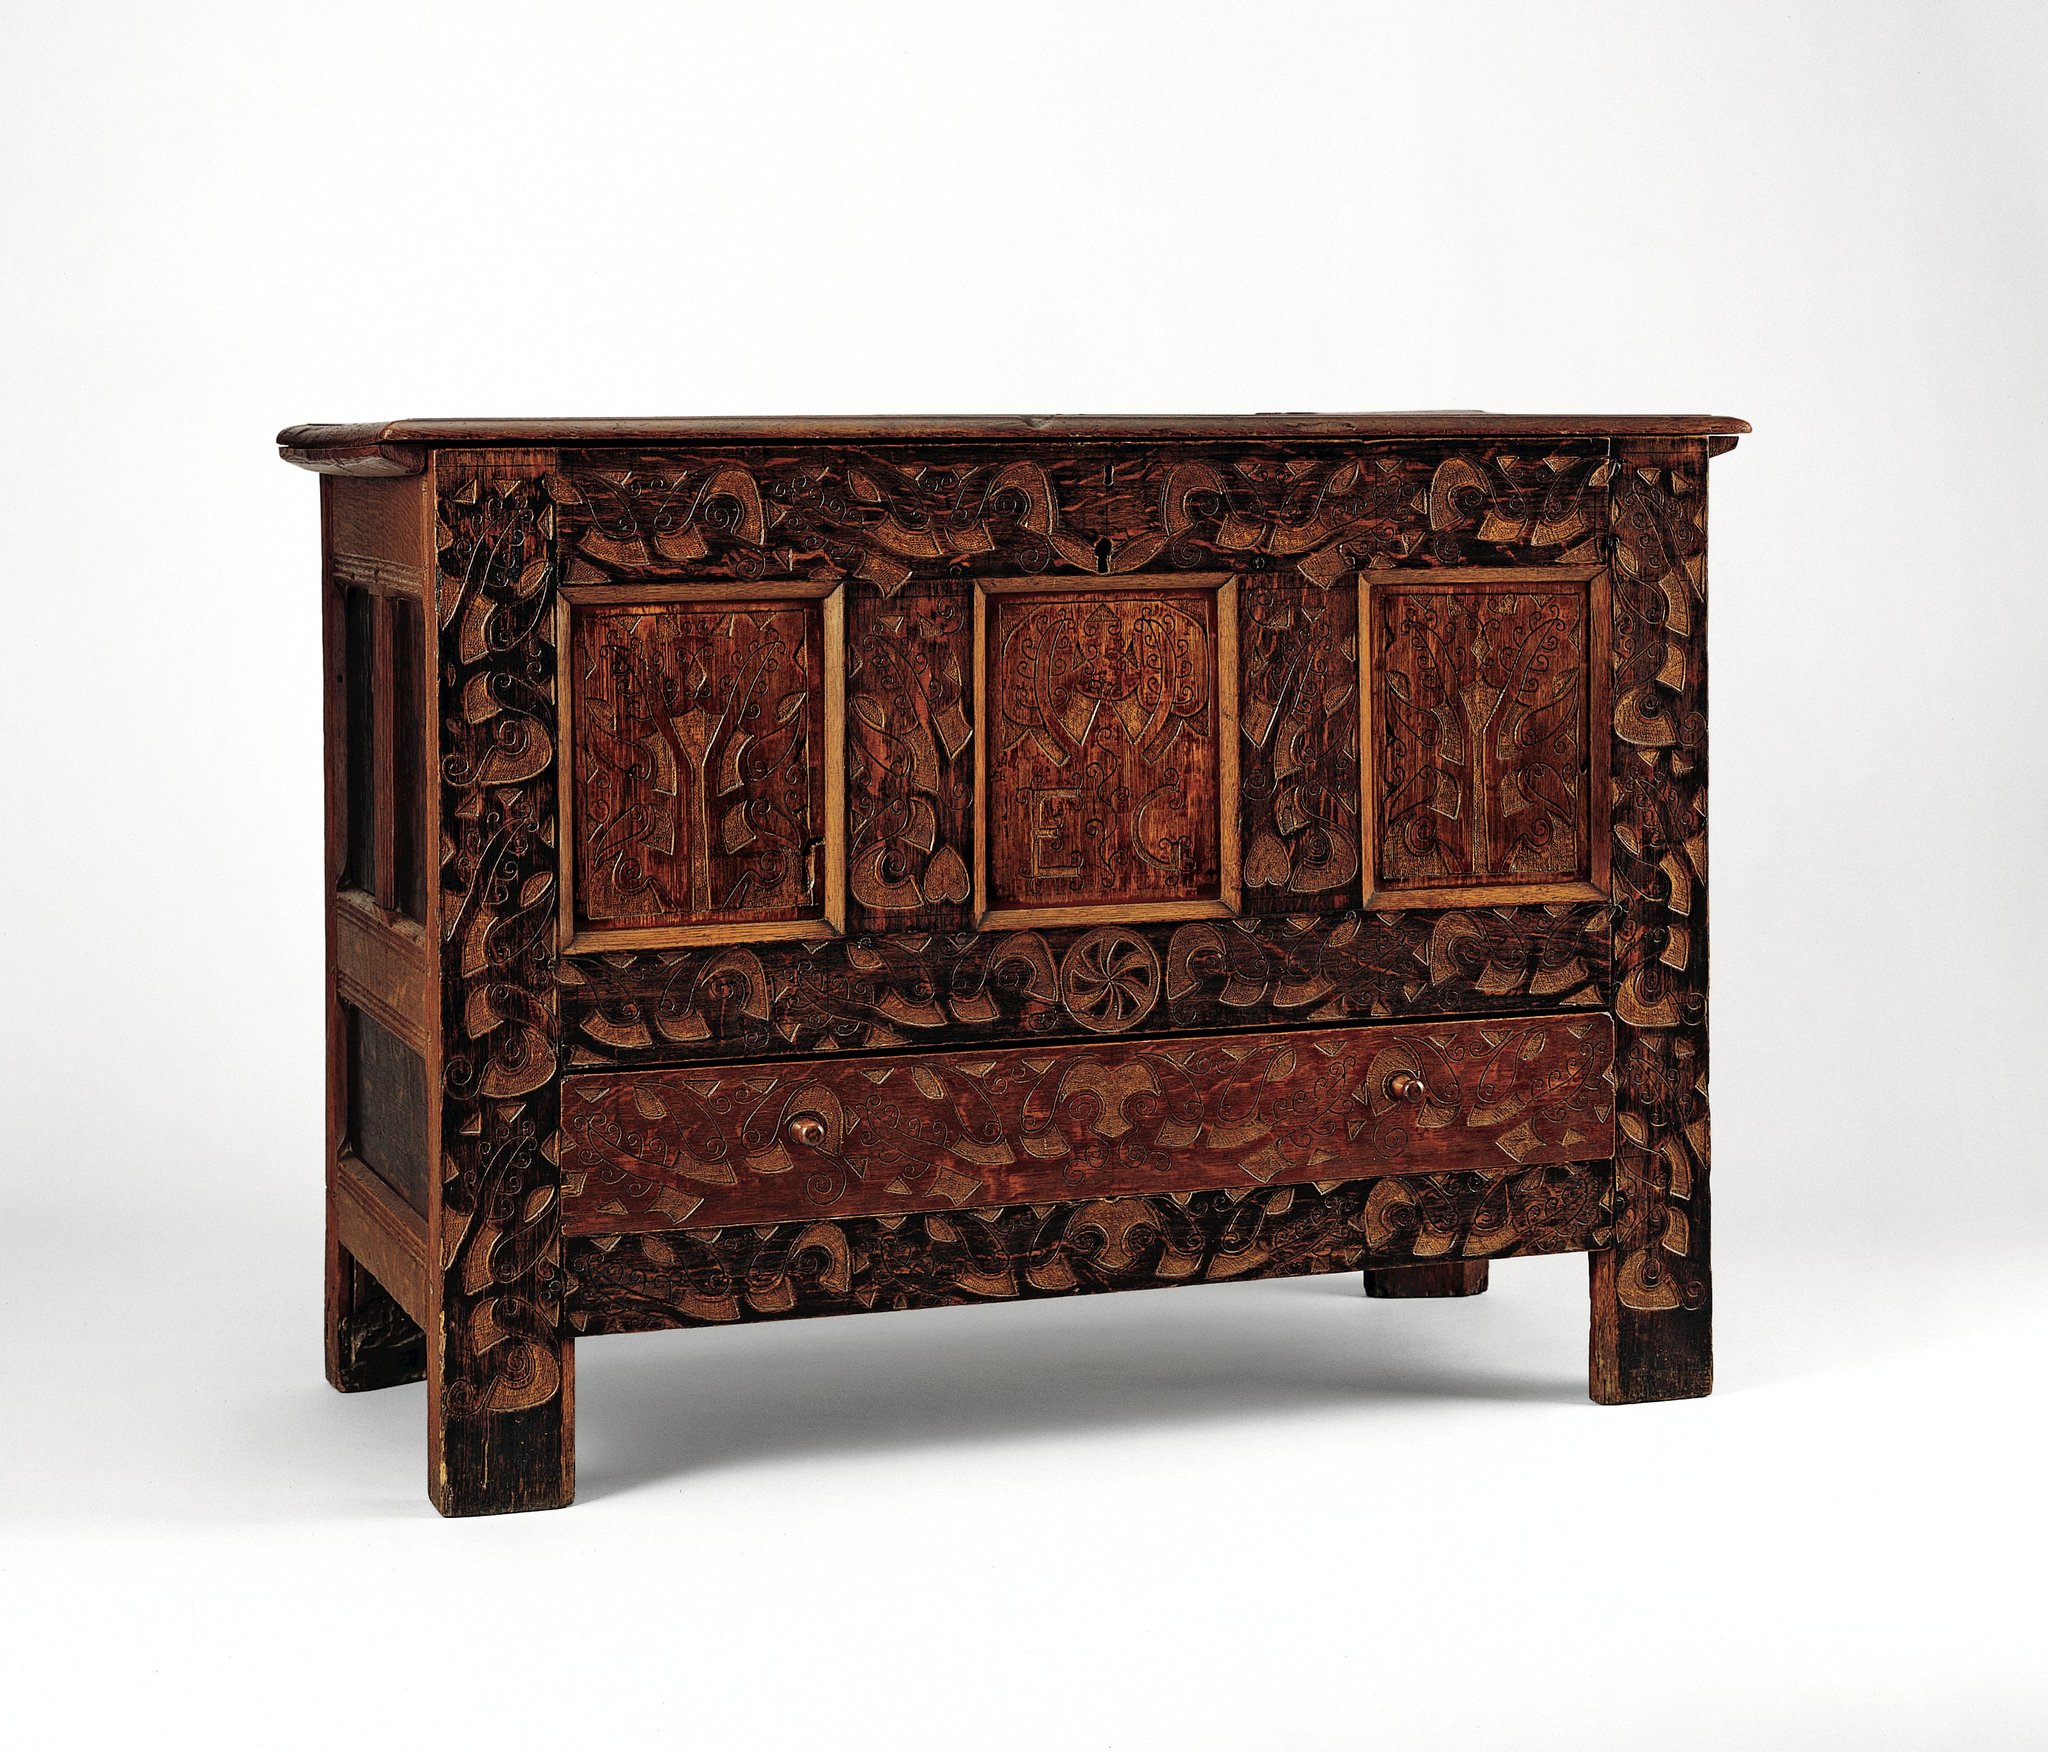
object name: chest of drawer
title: Chest-with-drawer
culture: american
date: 1690-1710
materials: wood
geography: united states